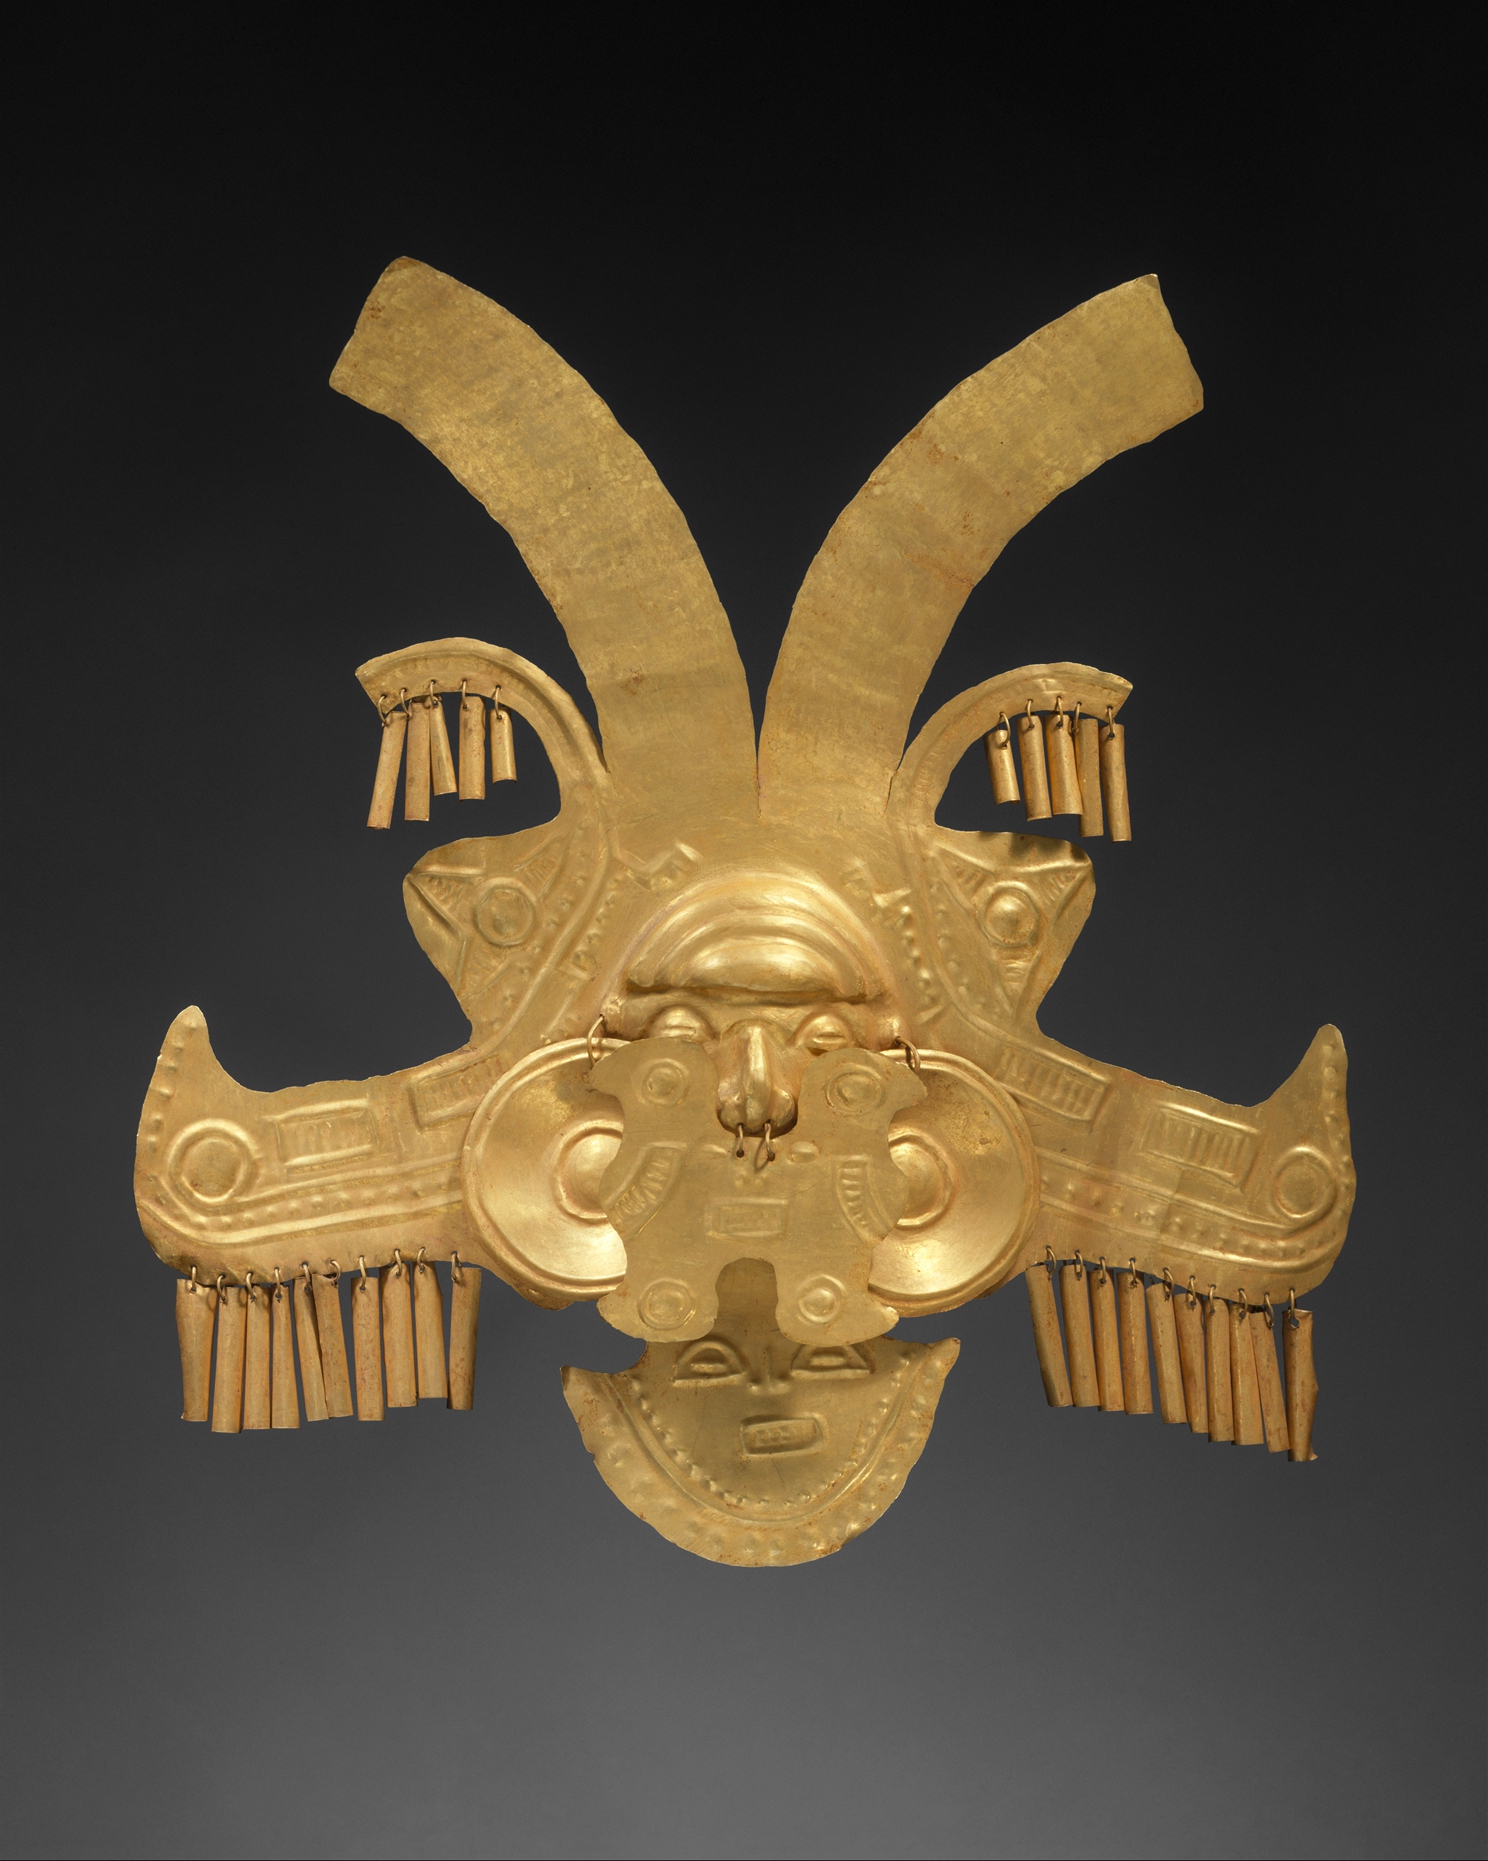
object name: headdress ornament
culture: calima or yotoco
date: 1-700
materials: gold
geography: colombia